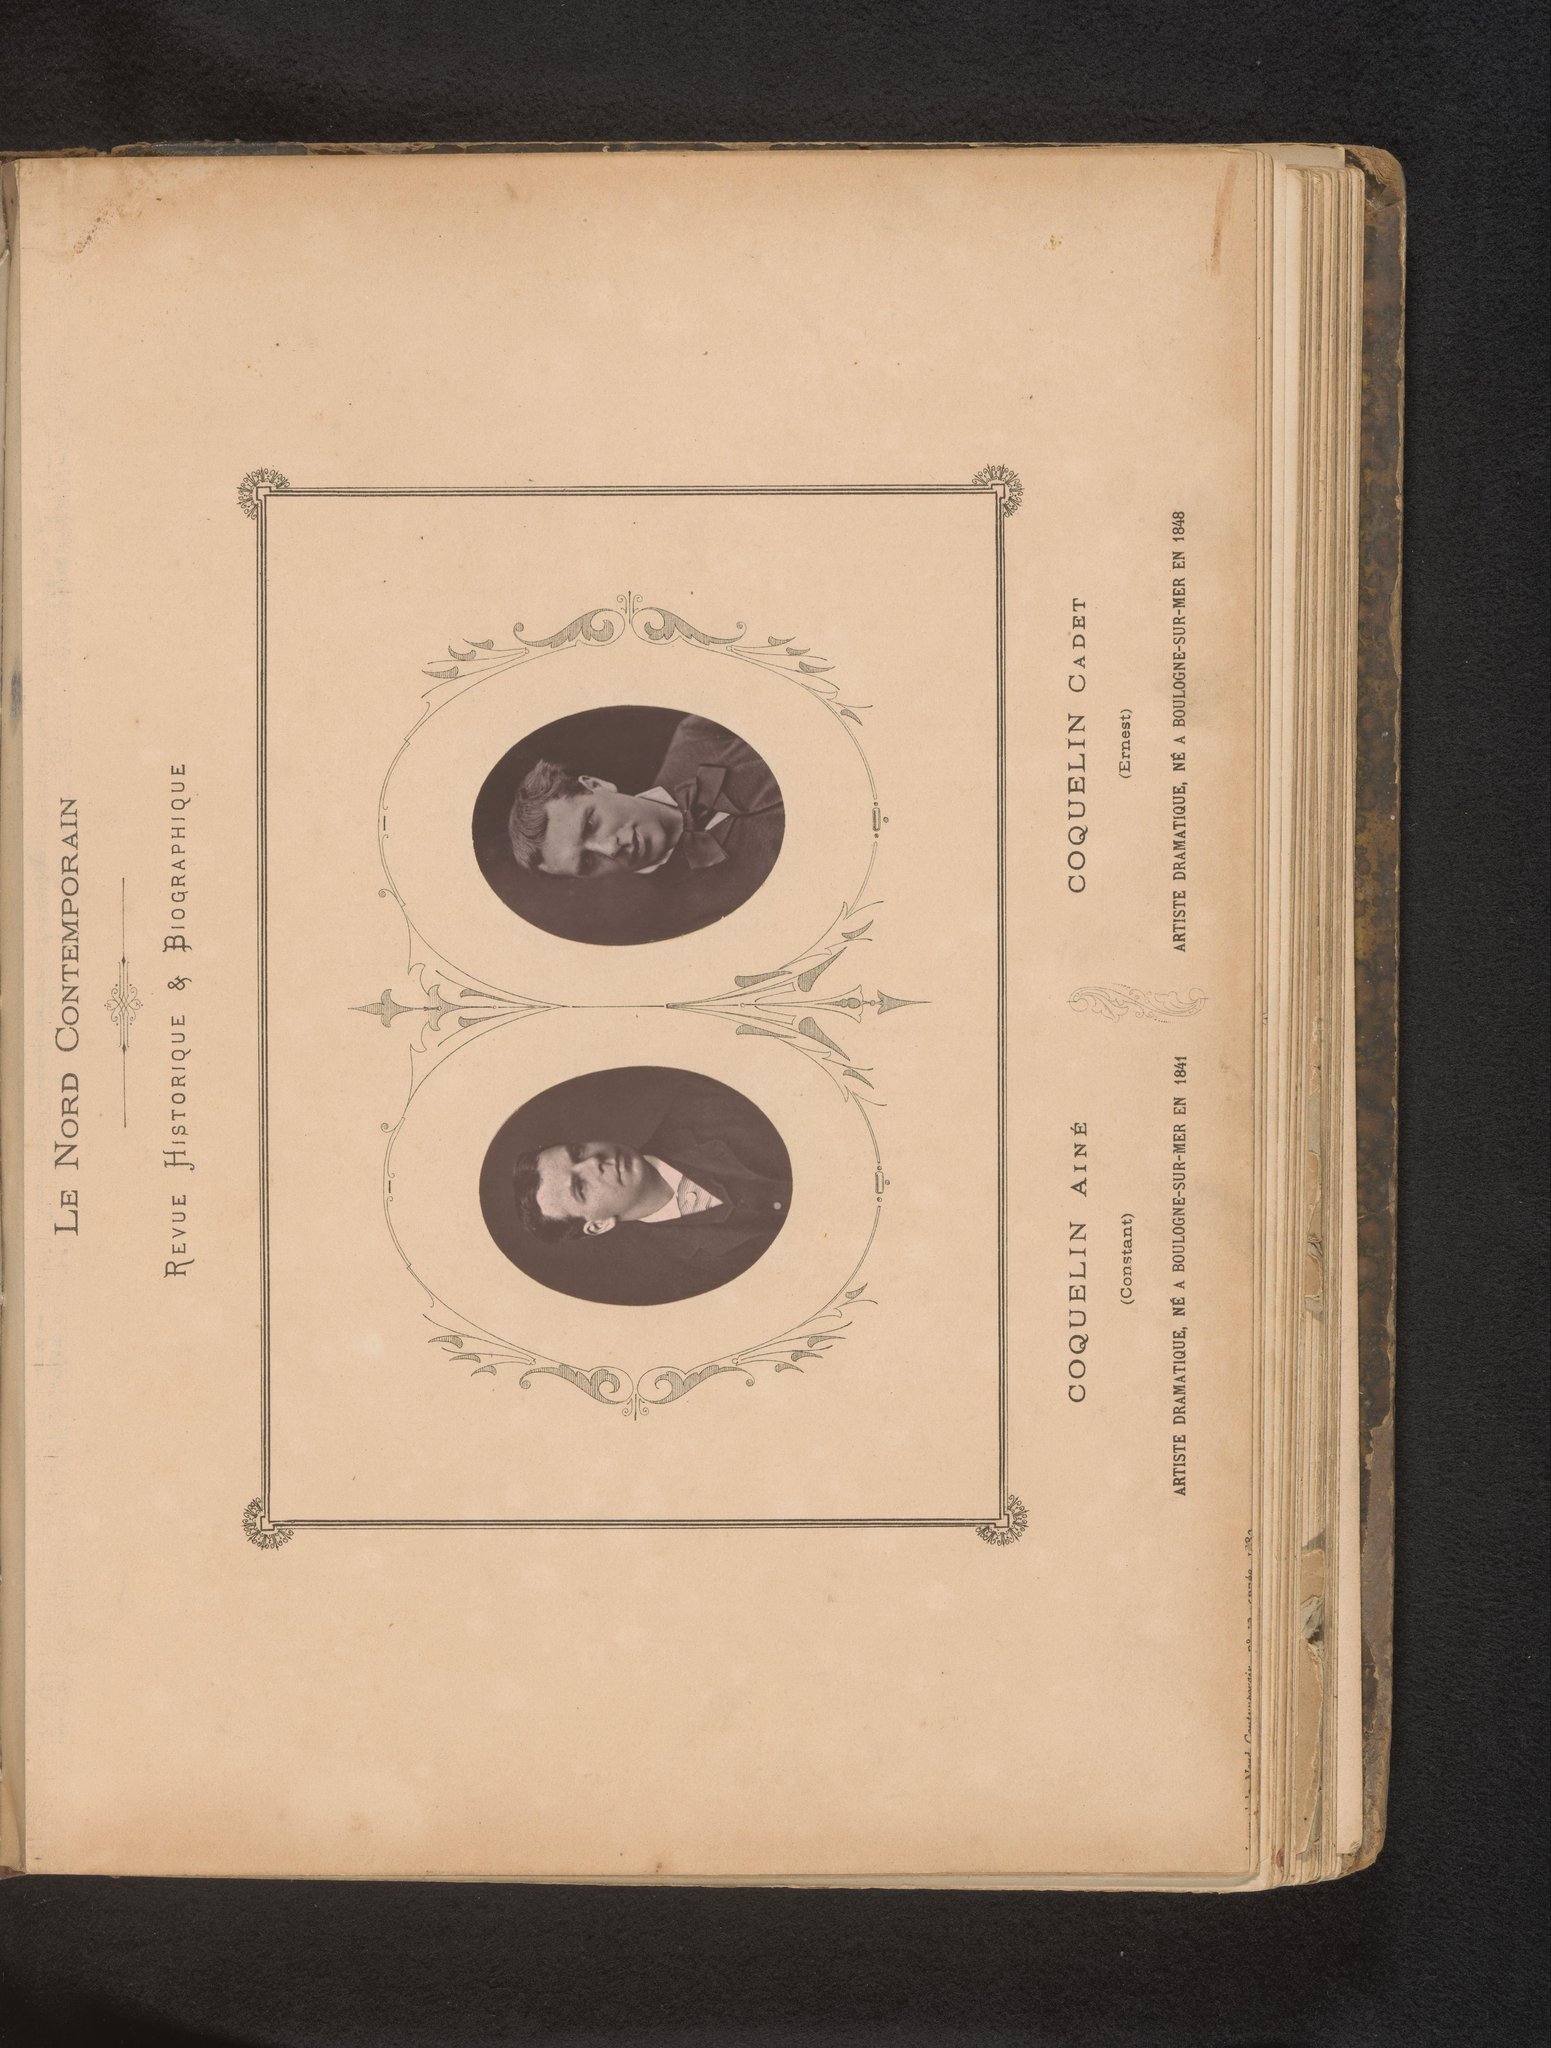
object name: page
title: Coquelin Cadet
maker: Anonymous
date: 1878-1882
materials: paper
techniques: woodburytype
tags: historical persons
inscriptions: inscription: ‘Le Nord Contemporain/ Revue Historique & Biographique’, inscription: ‘Ariste dramatique, né a Boulogne-sur-Mer en 1848’